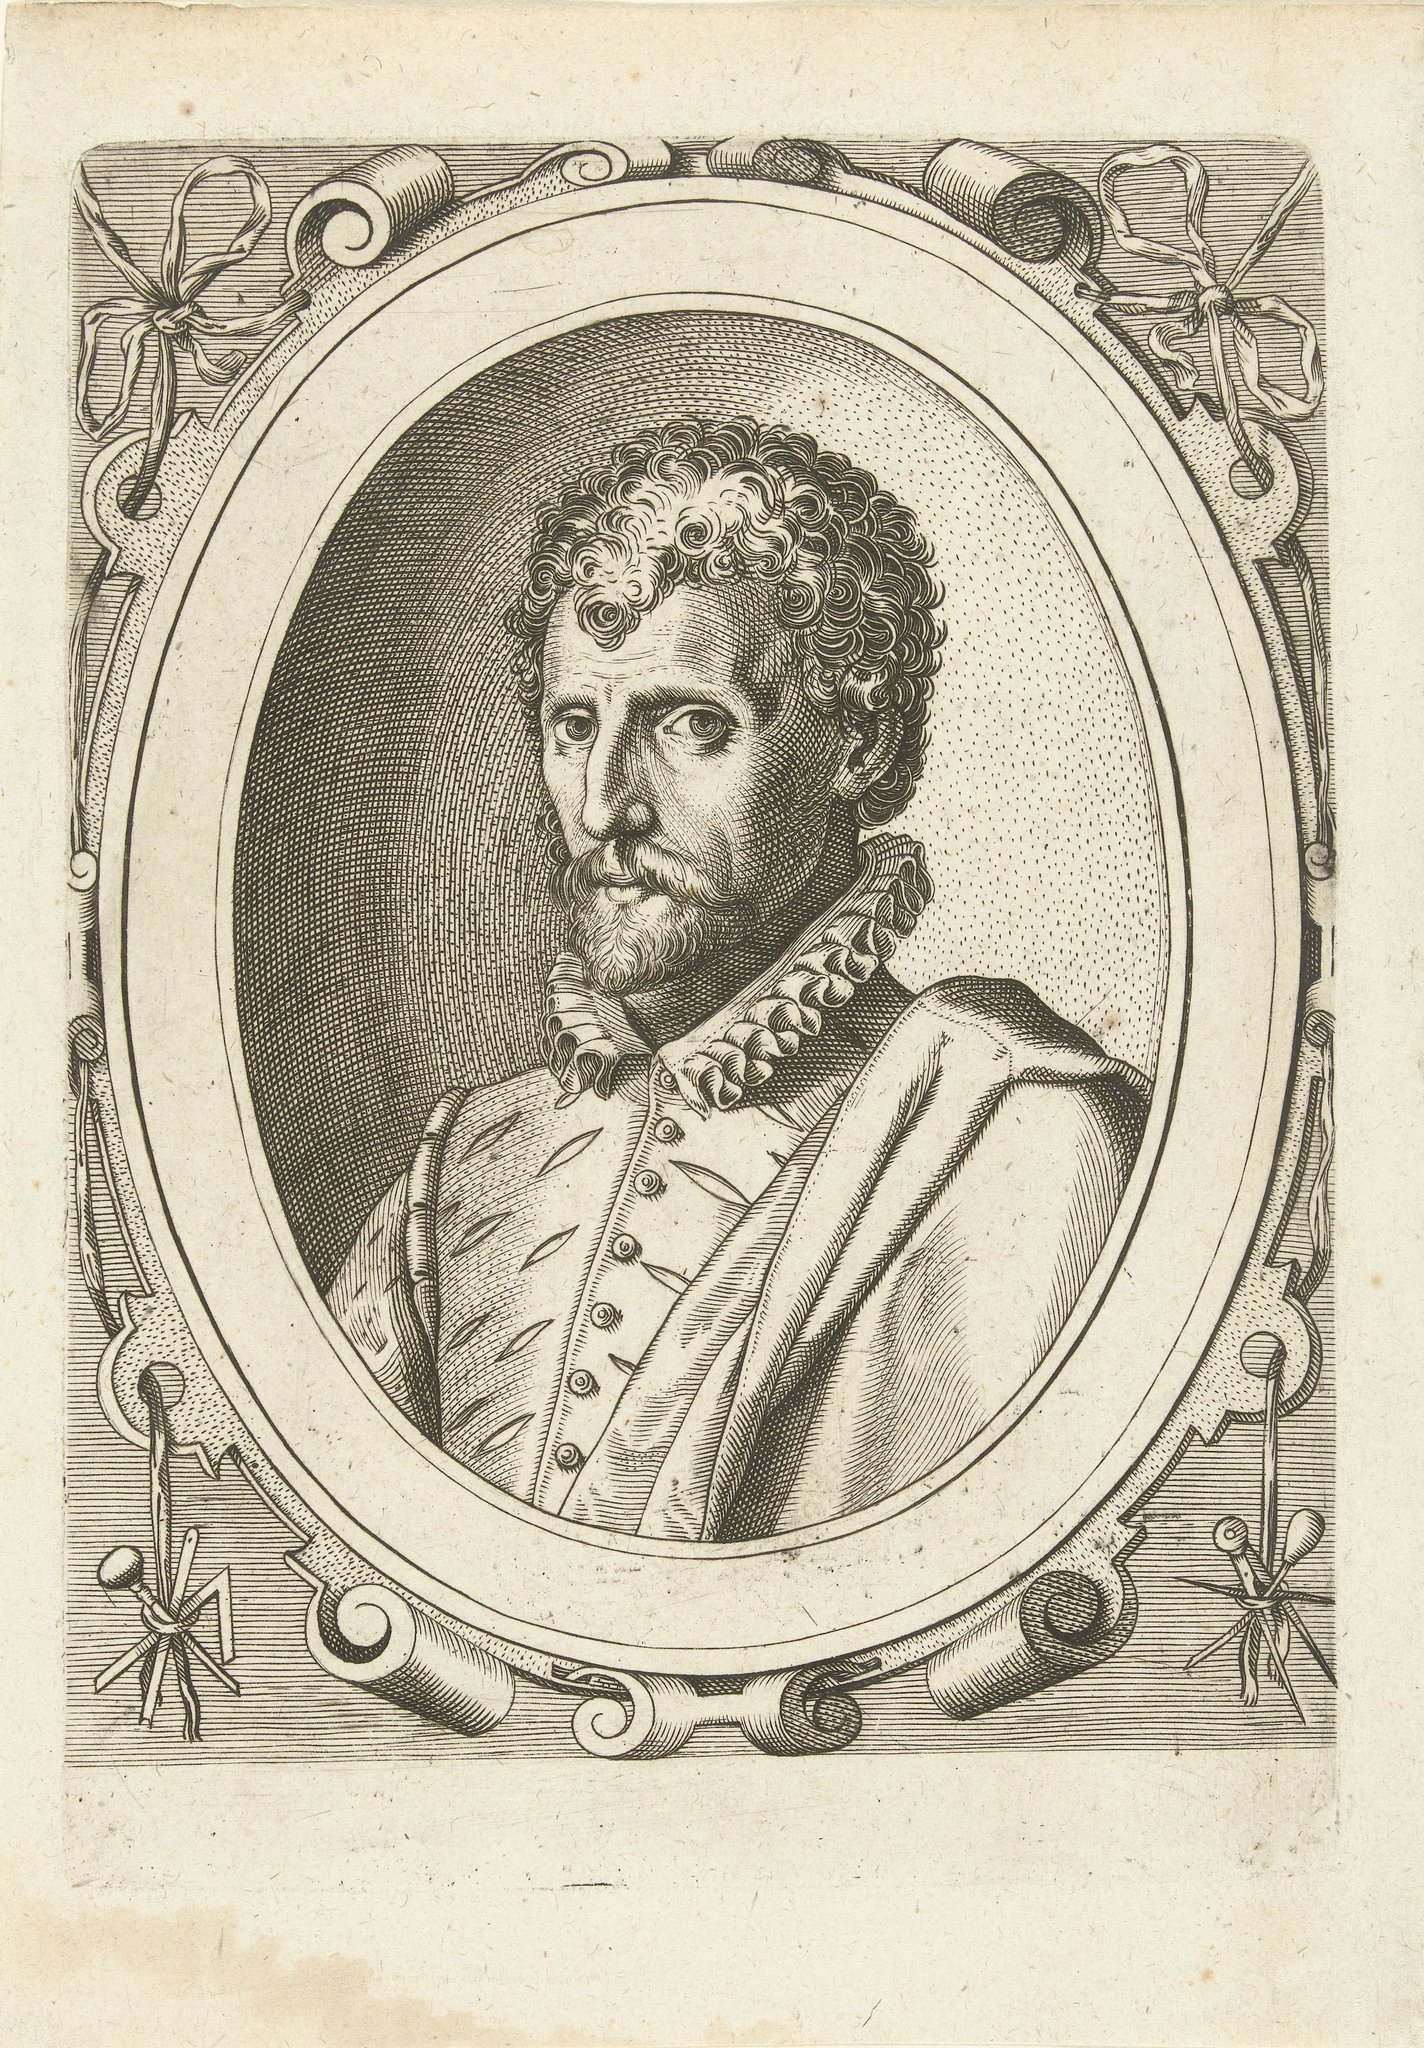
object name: print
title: Portret van Cornelis Cort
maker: Anonymous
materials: paper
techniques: engraving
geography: antwerp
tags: print maker, cornelis cort, historical persons, portrait, self-portrait of graphic artist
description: Portret van de graveur Cornelis Cort, op 42- jarige leeftijd, in ovaal.